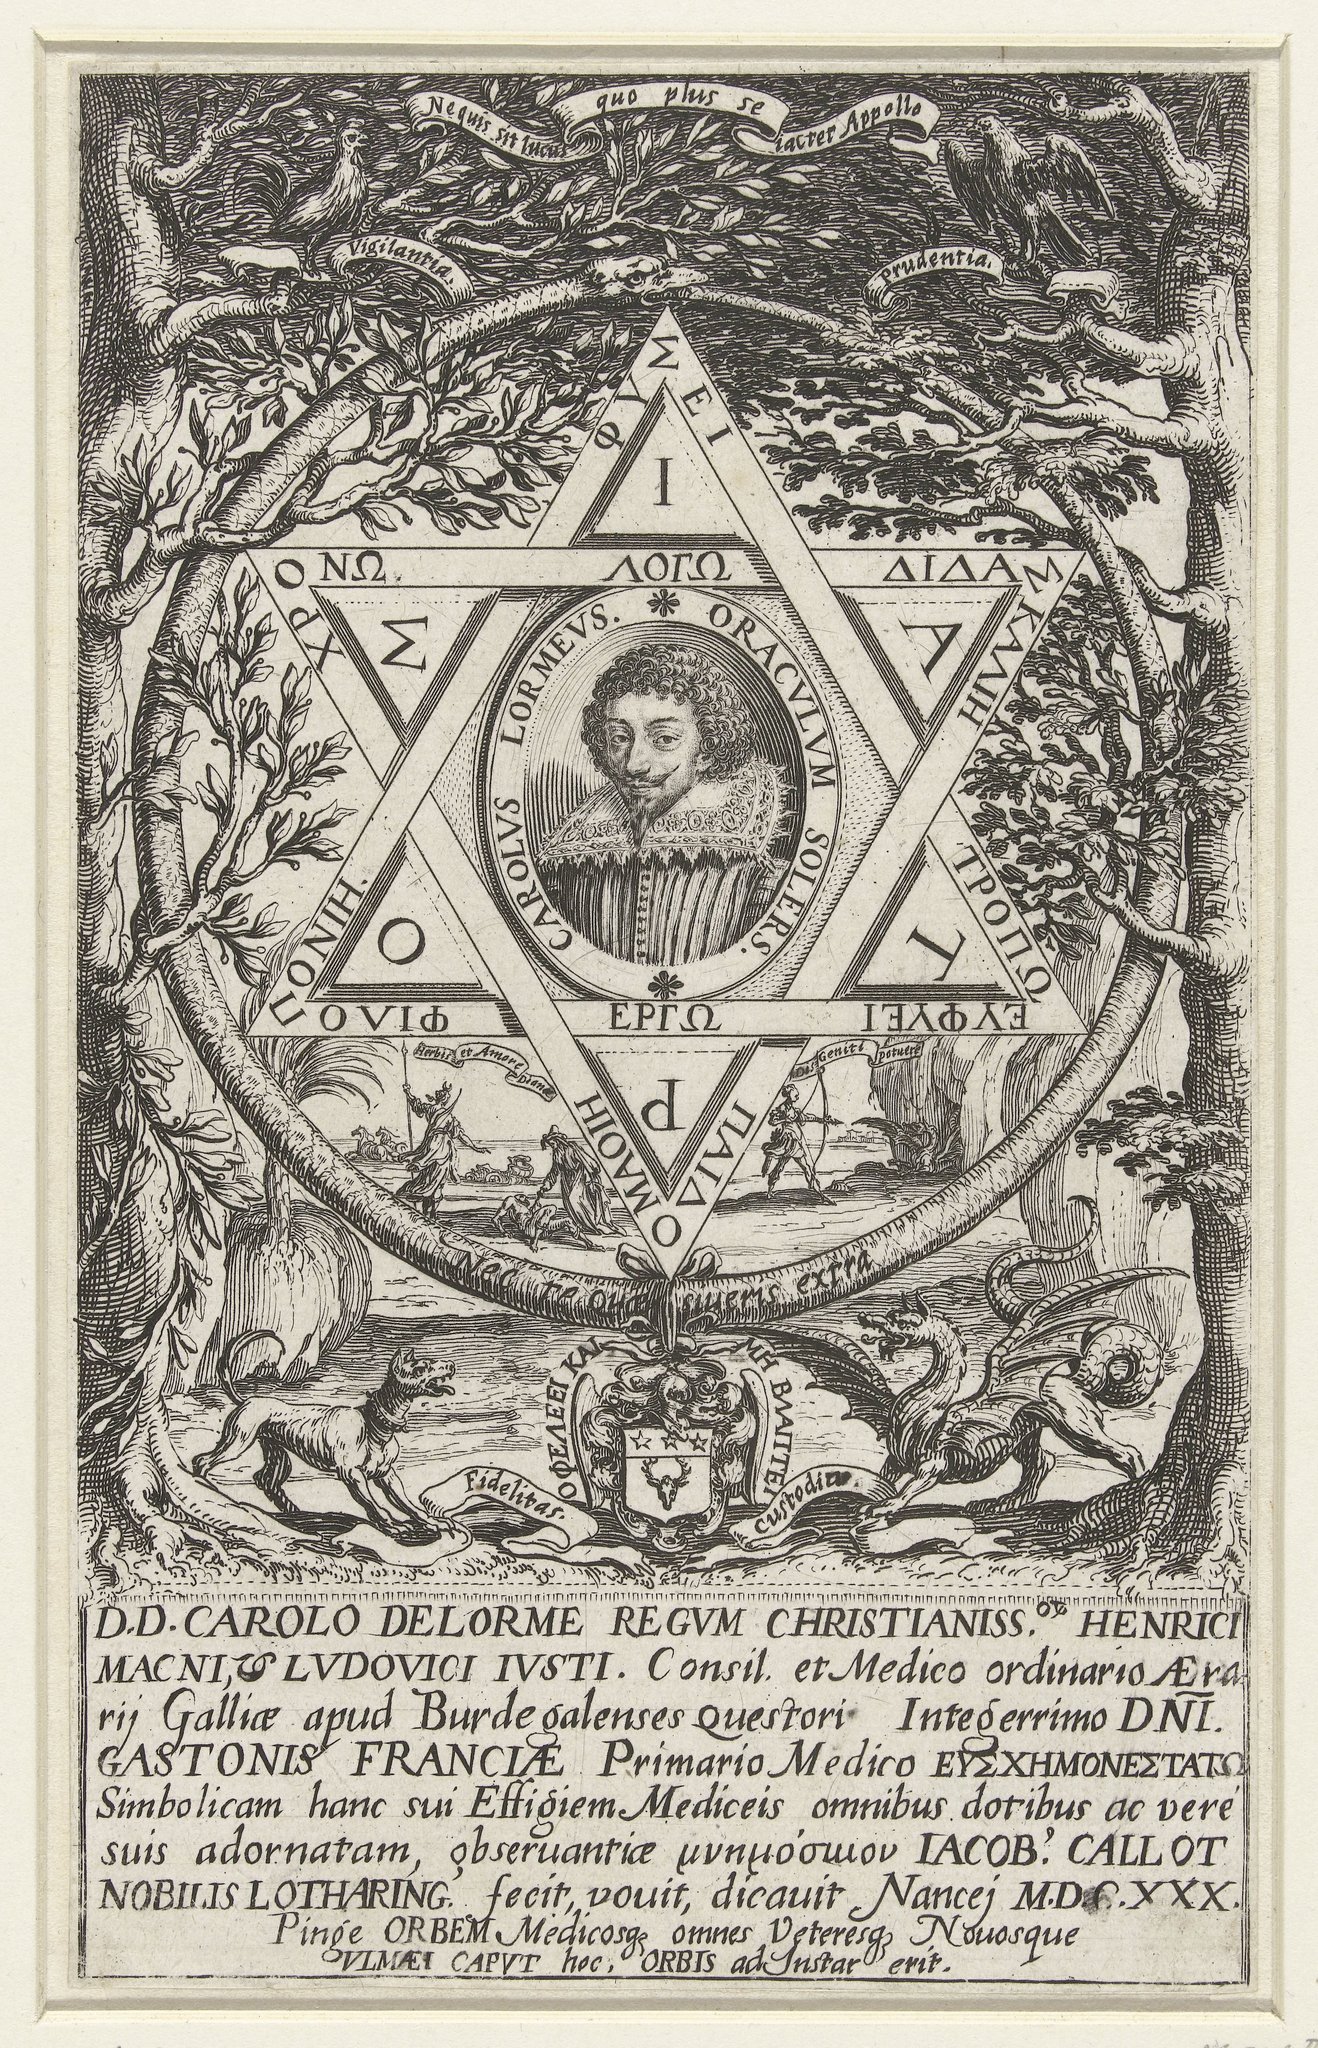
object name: print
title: Portret van de arts Charles Delorme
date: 1630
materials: paper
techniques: etching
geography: nancy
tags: charles delorme, historical persons, physician, doctor, serpent ouroboros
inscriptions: date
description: Ovaal busteportret van Charles Delorme, lijfarts van de koningen Hendrik IV en Lodewijk XIII van Frankrijk. Om het ovaal met de beeltenis een zeskantige ster en daaromheen een slang die in zijn eigen staart bijt. Dit geheel wordt vastgehouden door de takken van twee bomen. Linksboven een haan, rechtsboven een adelaar, rechtsonder een draak en linksonder een hond. Met Latijnse en Griekse teksten in banderollen, als randschriften en als onderschrift.